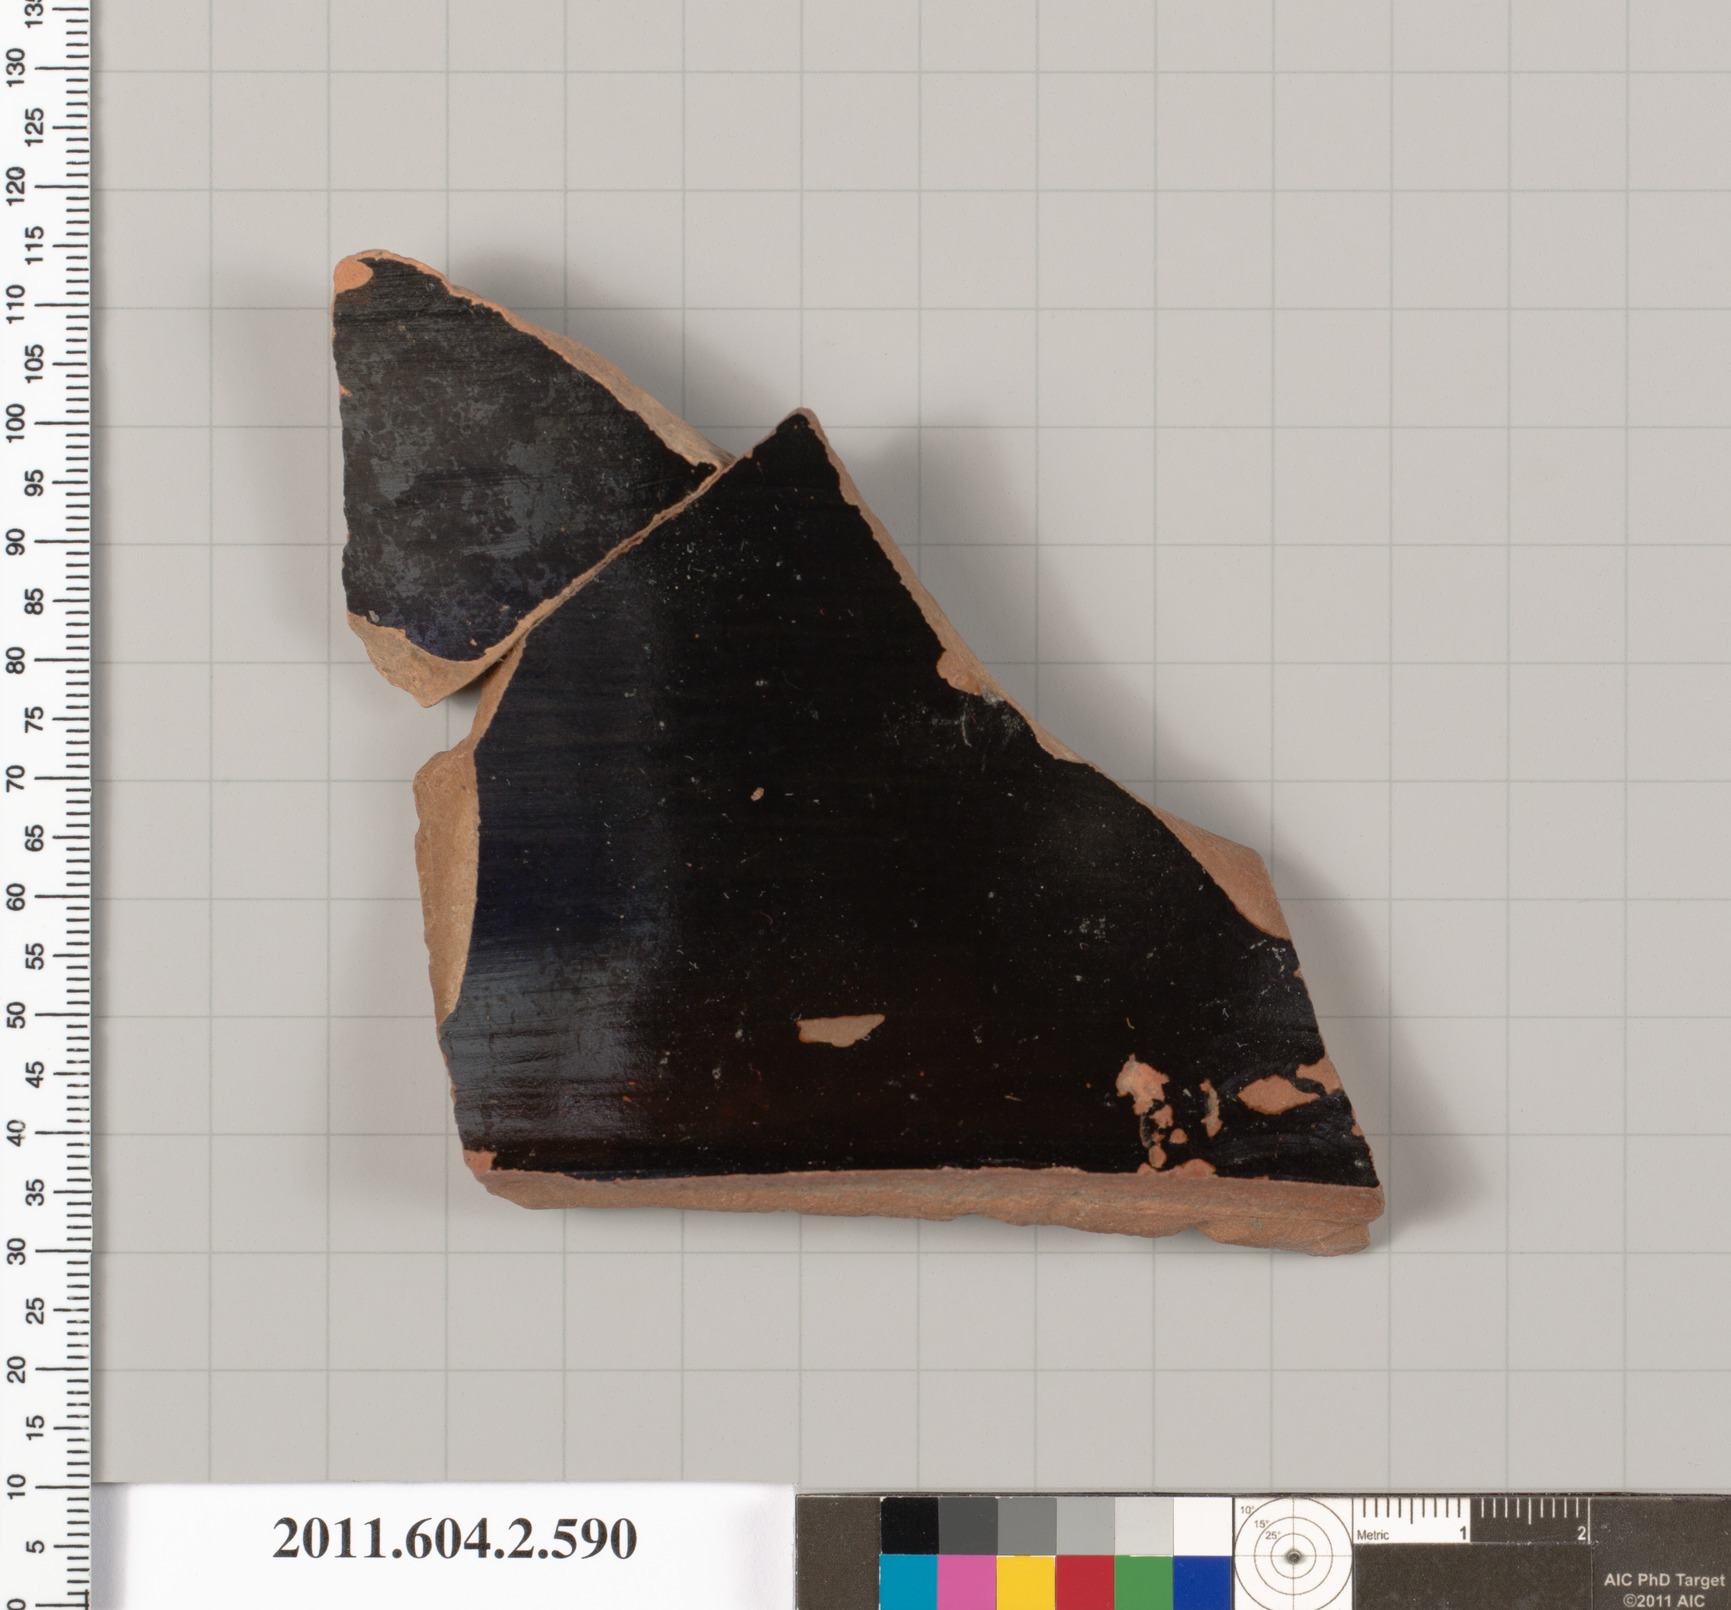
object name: column krater fragment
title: Terracotta fragment of a column-krater (bowl for mixing wine and water)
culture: greek, attic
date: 470-440 BCE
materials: terracotta